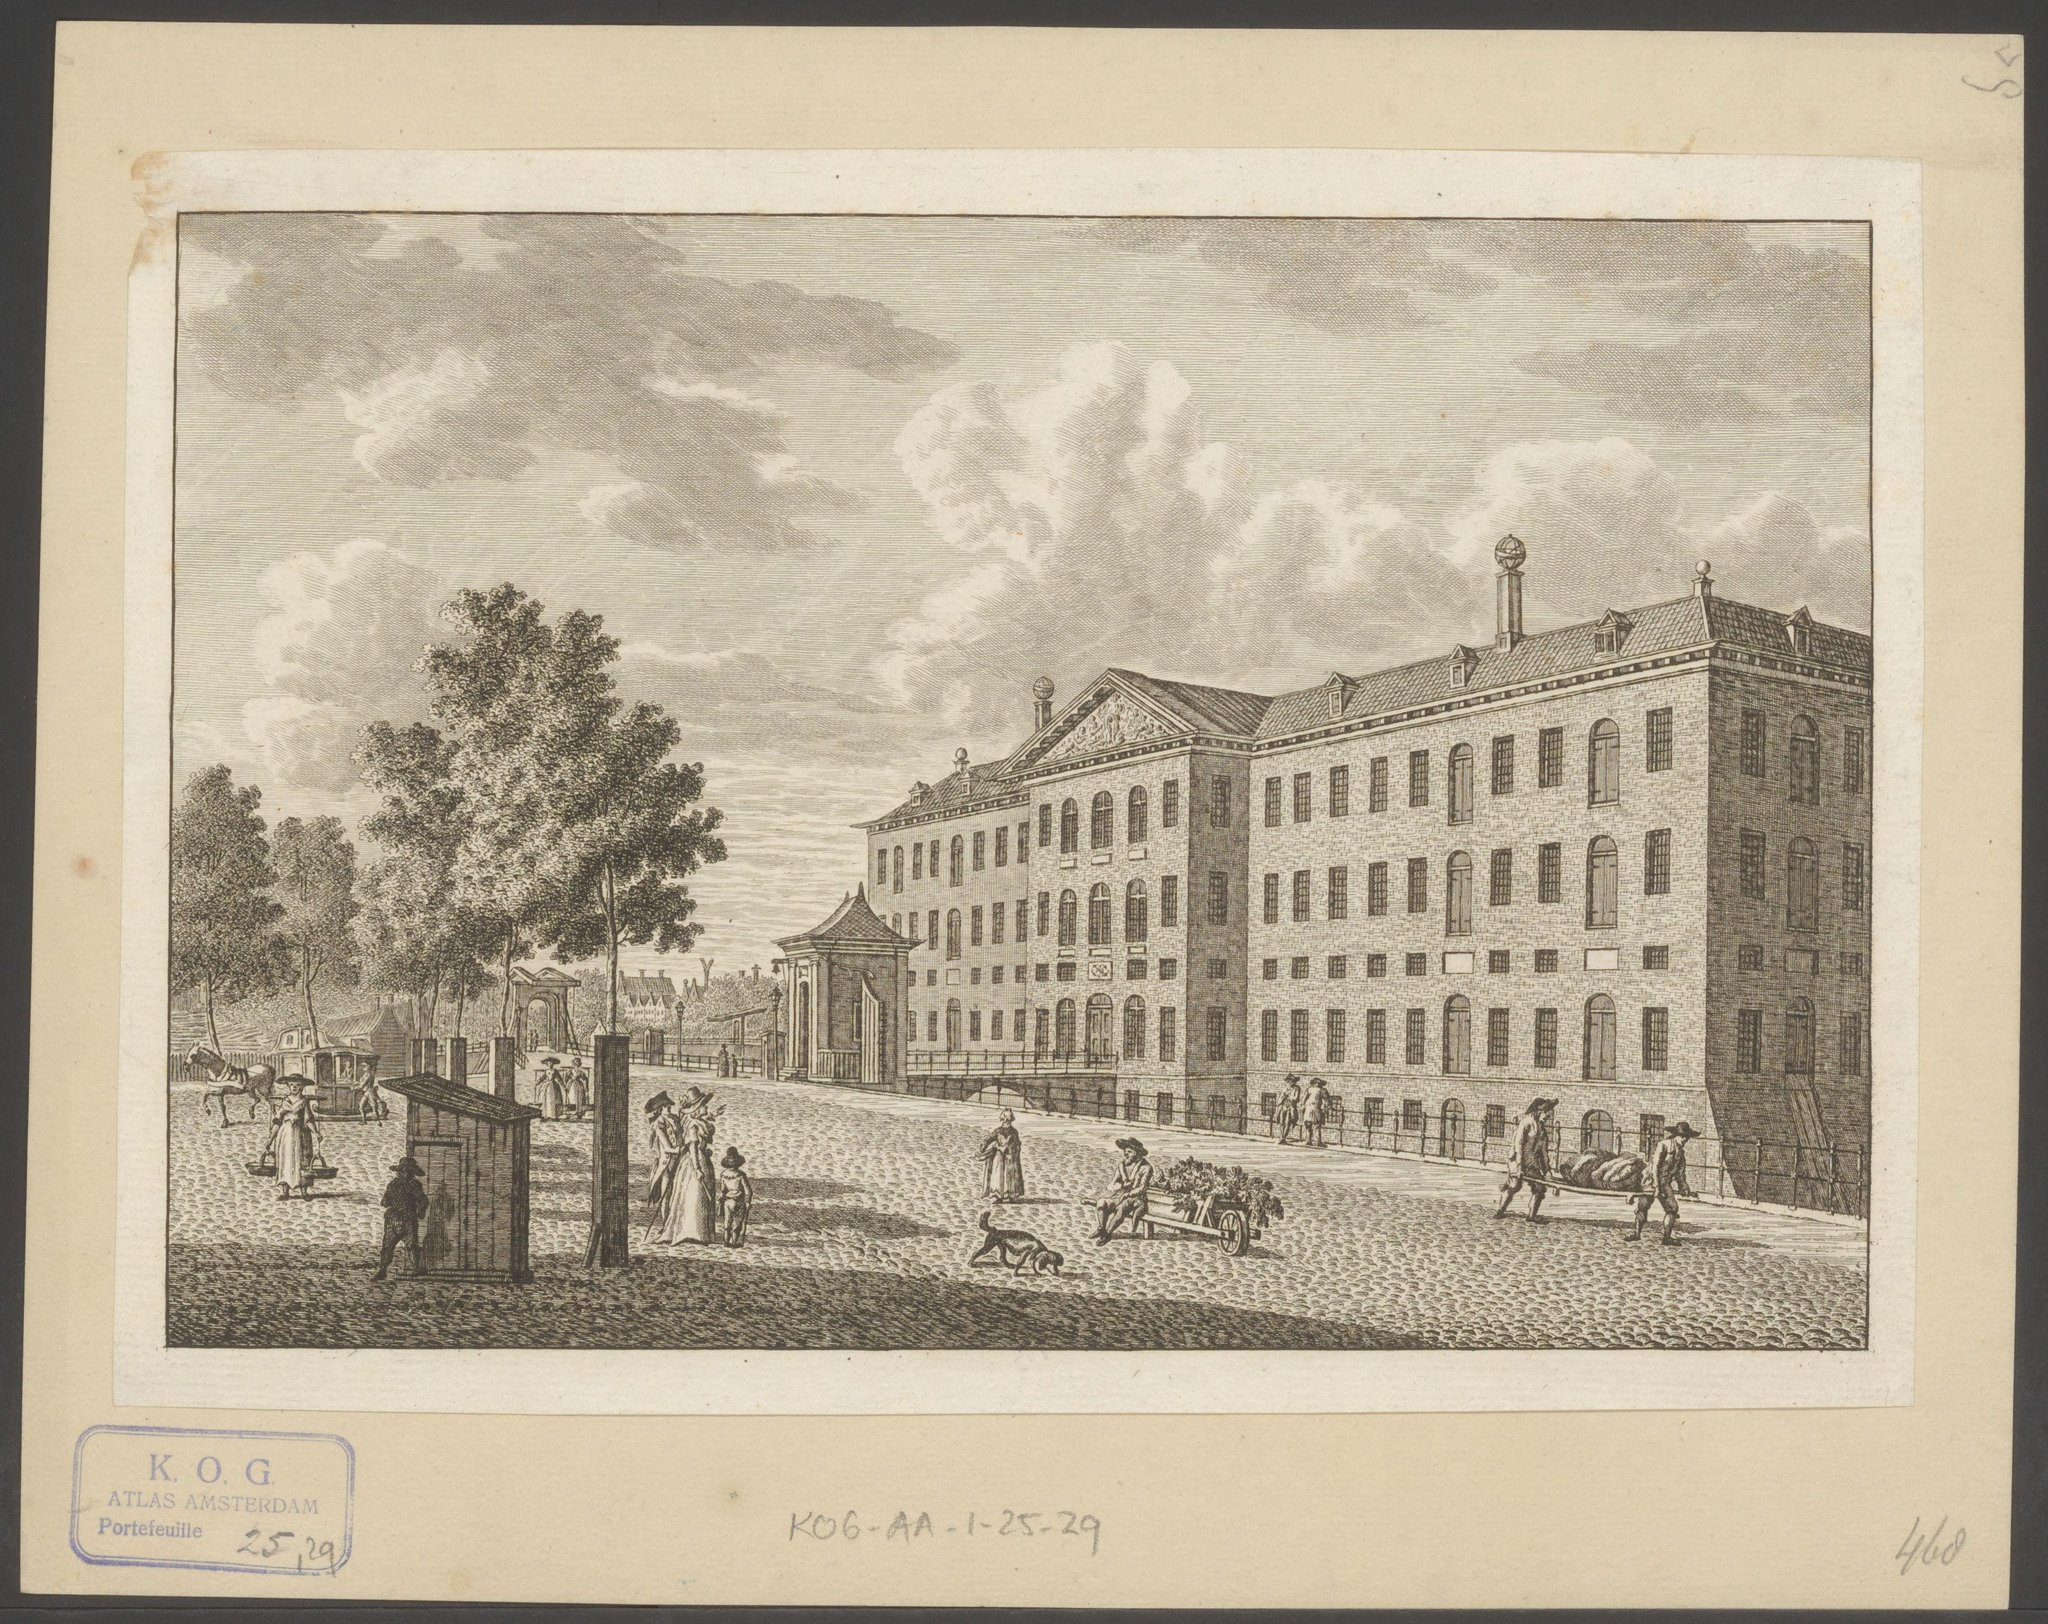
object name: print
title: 's Lands Zeemagazijn te Amsterdam, vóór de brand van 1791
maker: Anonymous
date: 1791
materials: paper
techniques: engraving, etching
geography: northern netherlands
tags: large-scale structure for storage, e.g.: warehouse, depot, silo, city-view in general; 'veduta', façade (of house or building)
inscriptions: collector's mark: ‘25.29’ Lugt 1641b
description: Prent met onderschrift gebruikt in: 's Lands zee-magazijn te Amsterdam, beschouwd vóór, bij en na den brand van den 5 en 6 July deezes jaars. Amsterdam: J.W. Smit, 1791.